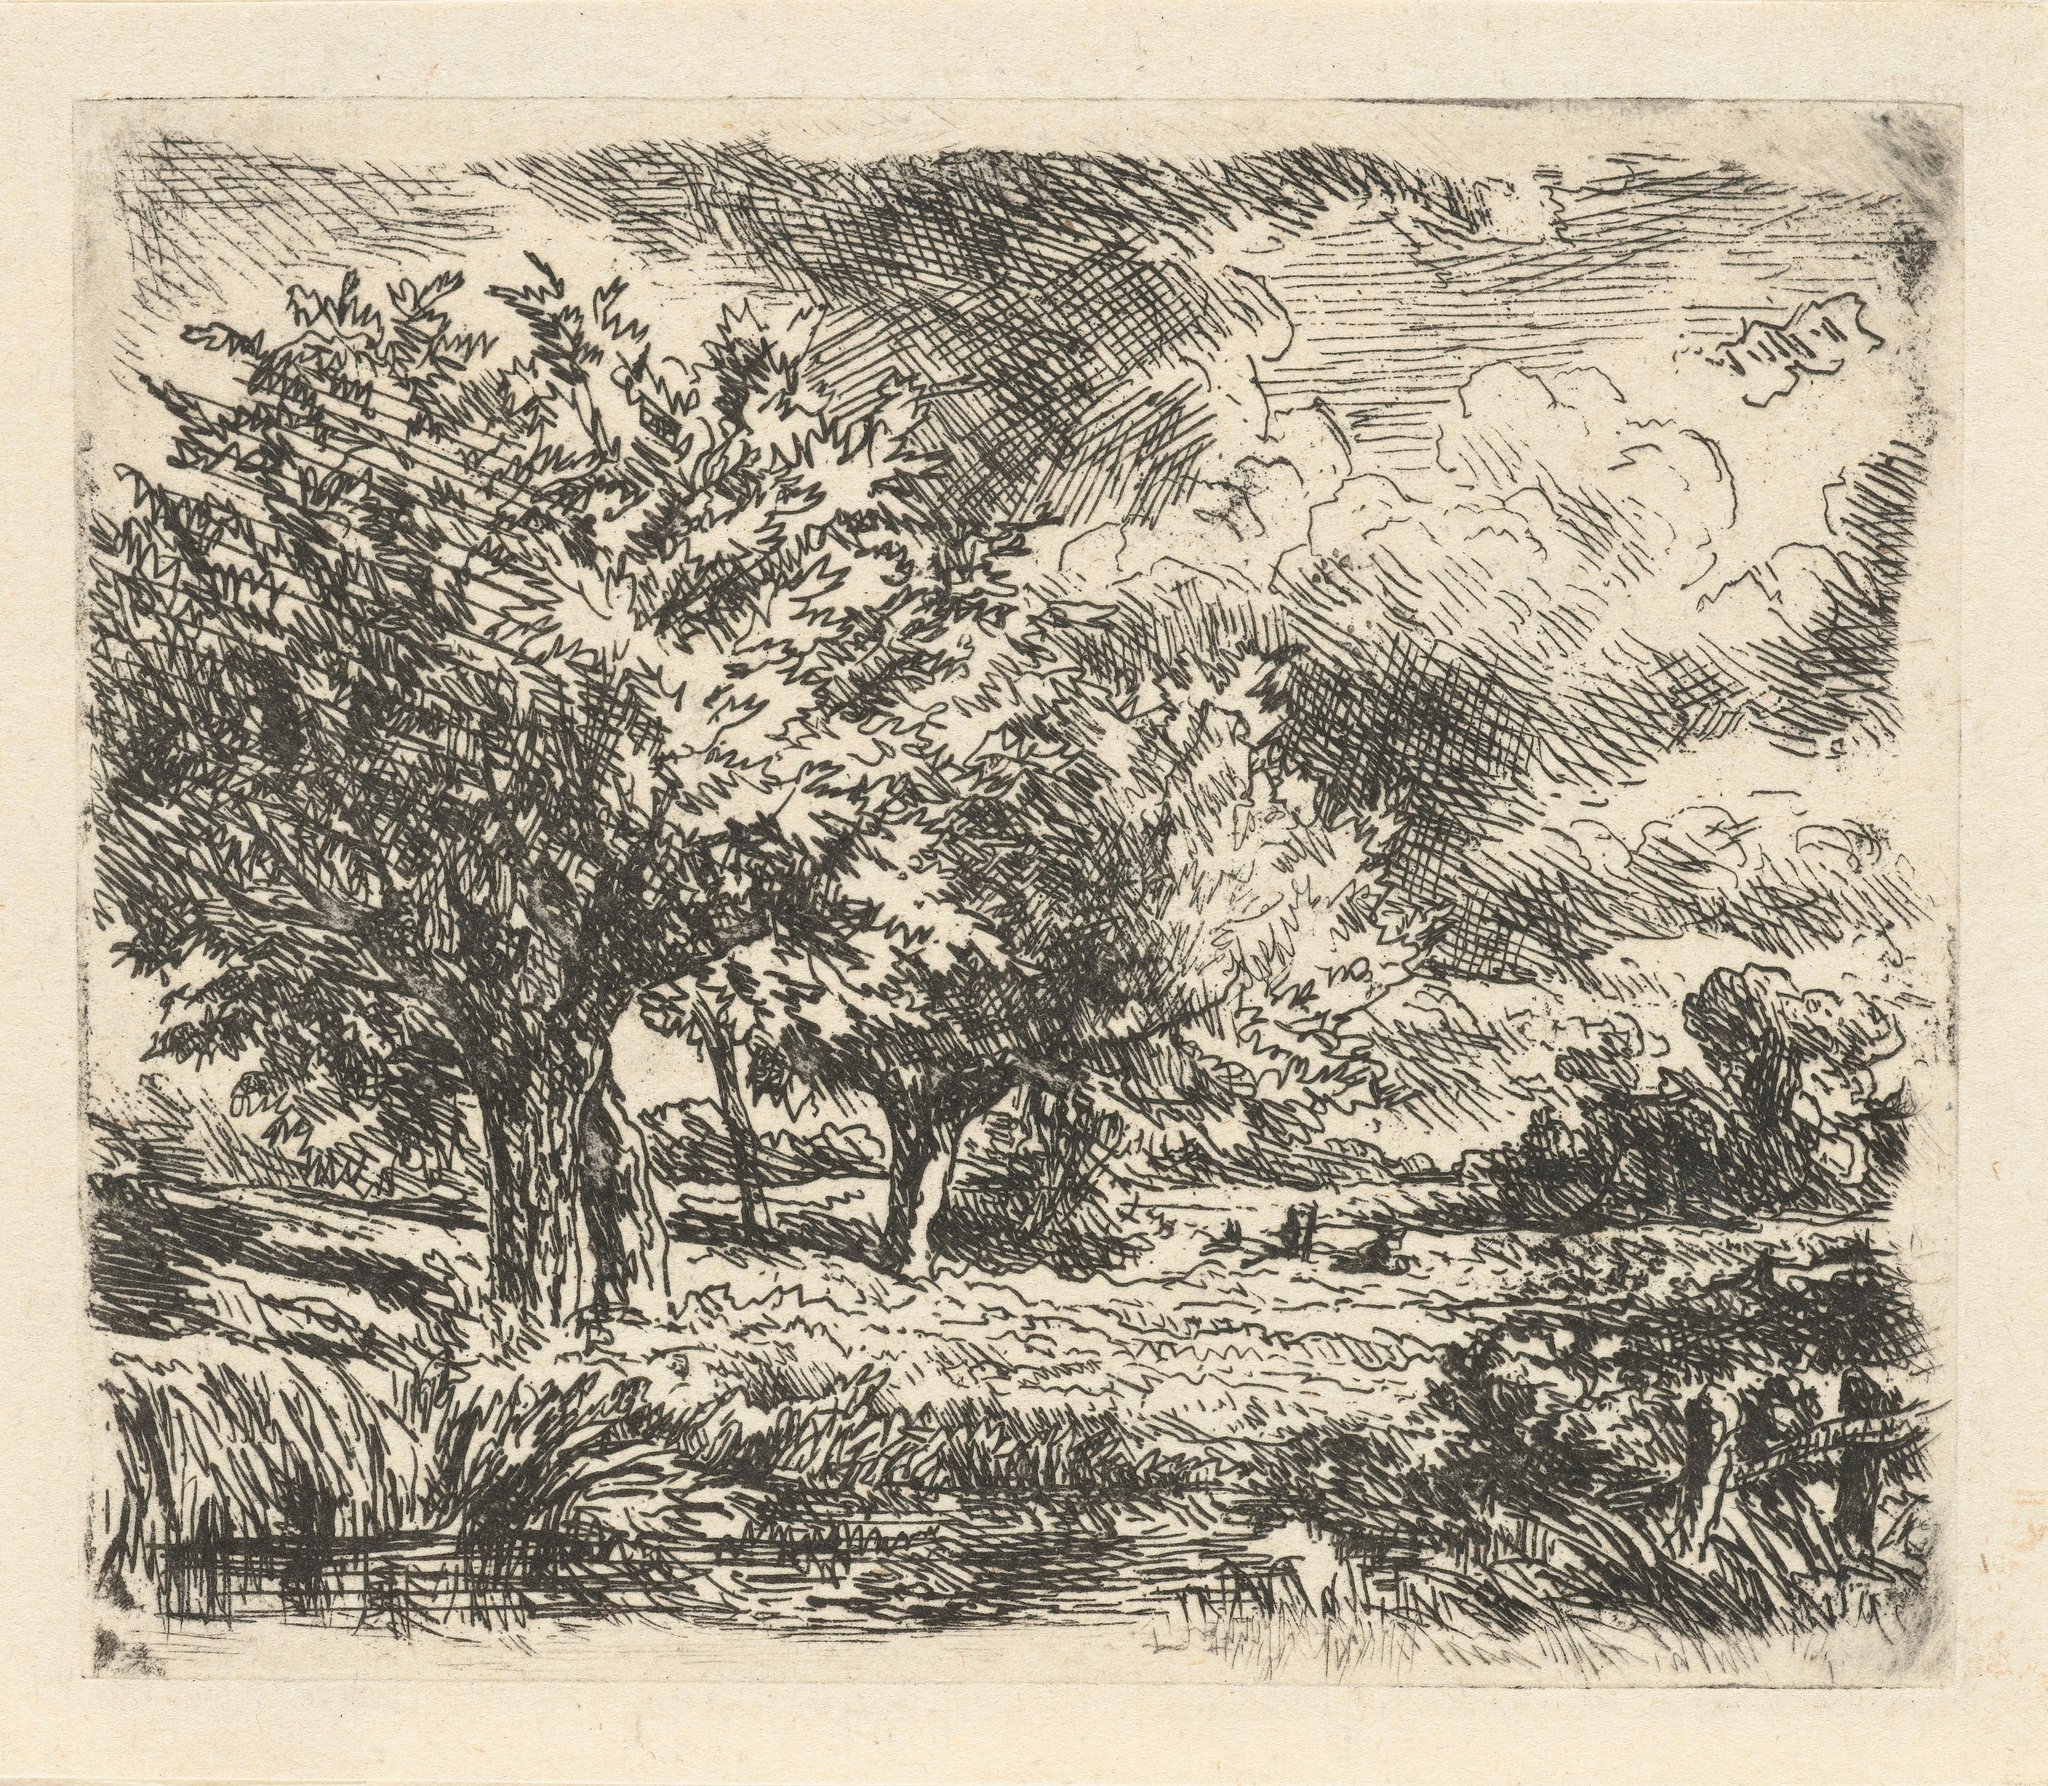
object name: print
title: Landschap met wilgen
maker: adrianus van everdingen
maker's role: print maker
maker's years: 1832-1912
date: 1842-1882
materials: paper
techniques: etching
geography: utrecht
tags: trees: willow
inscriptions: collector's mark: Lugt 2228